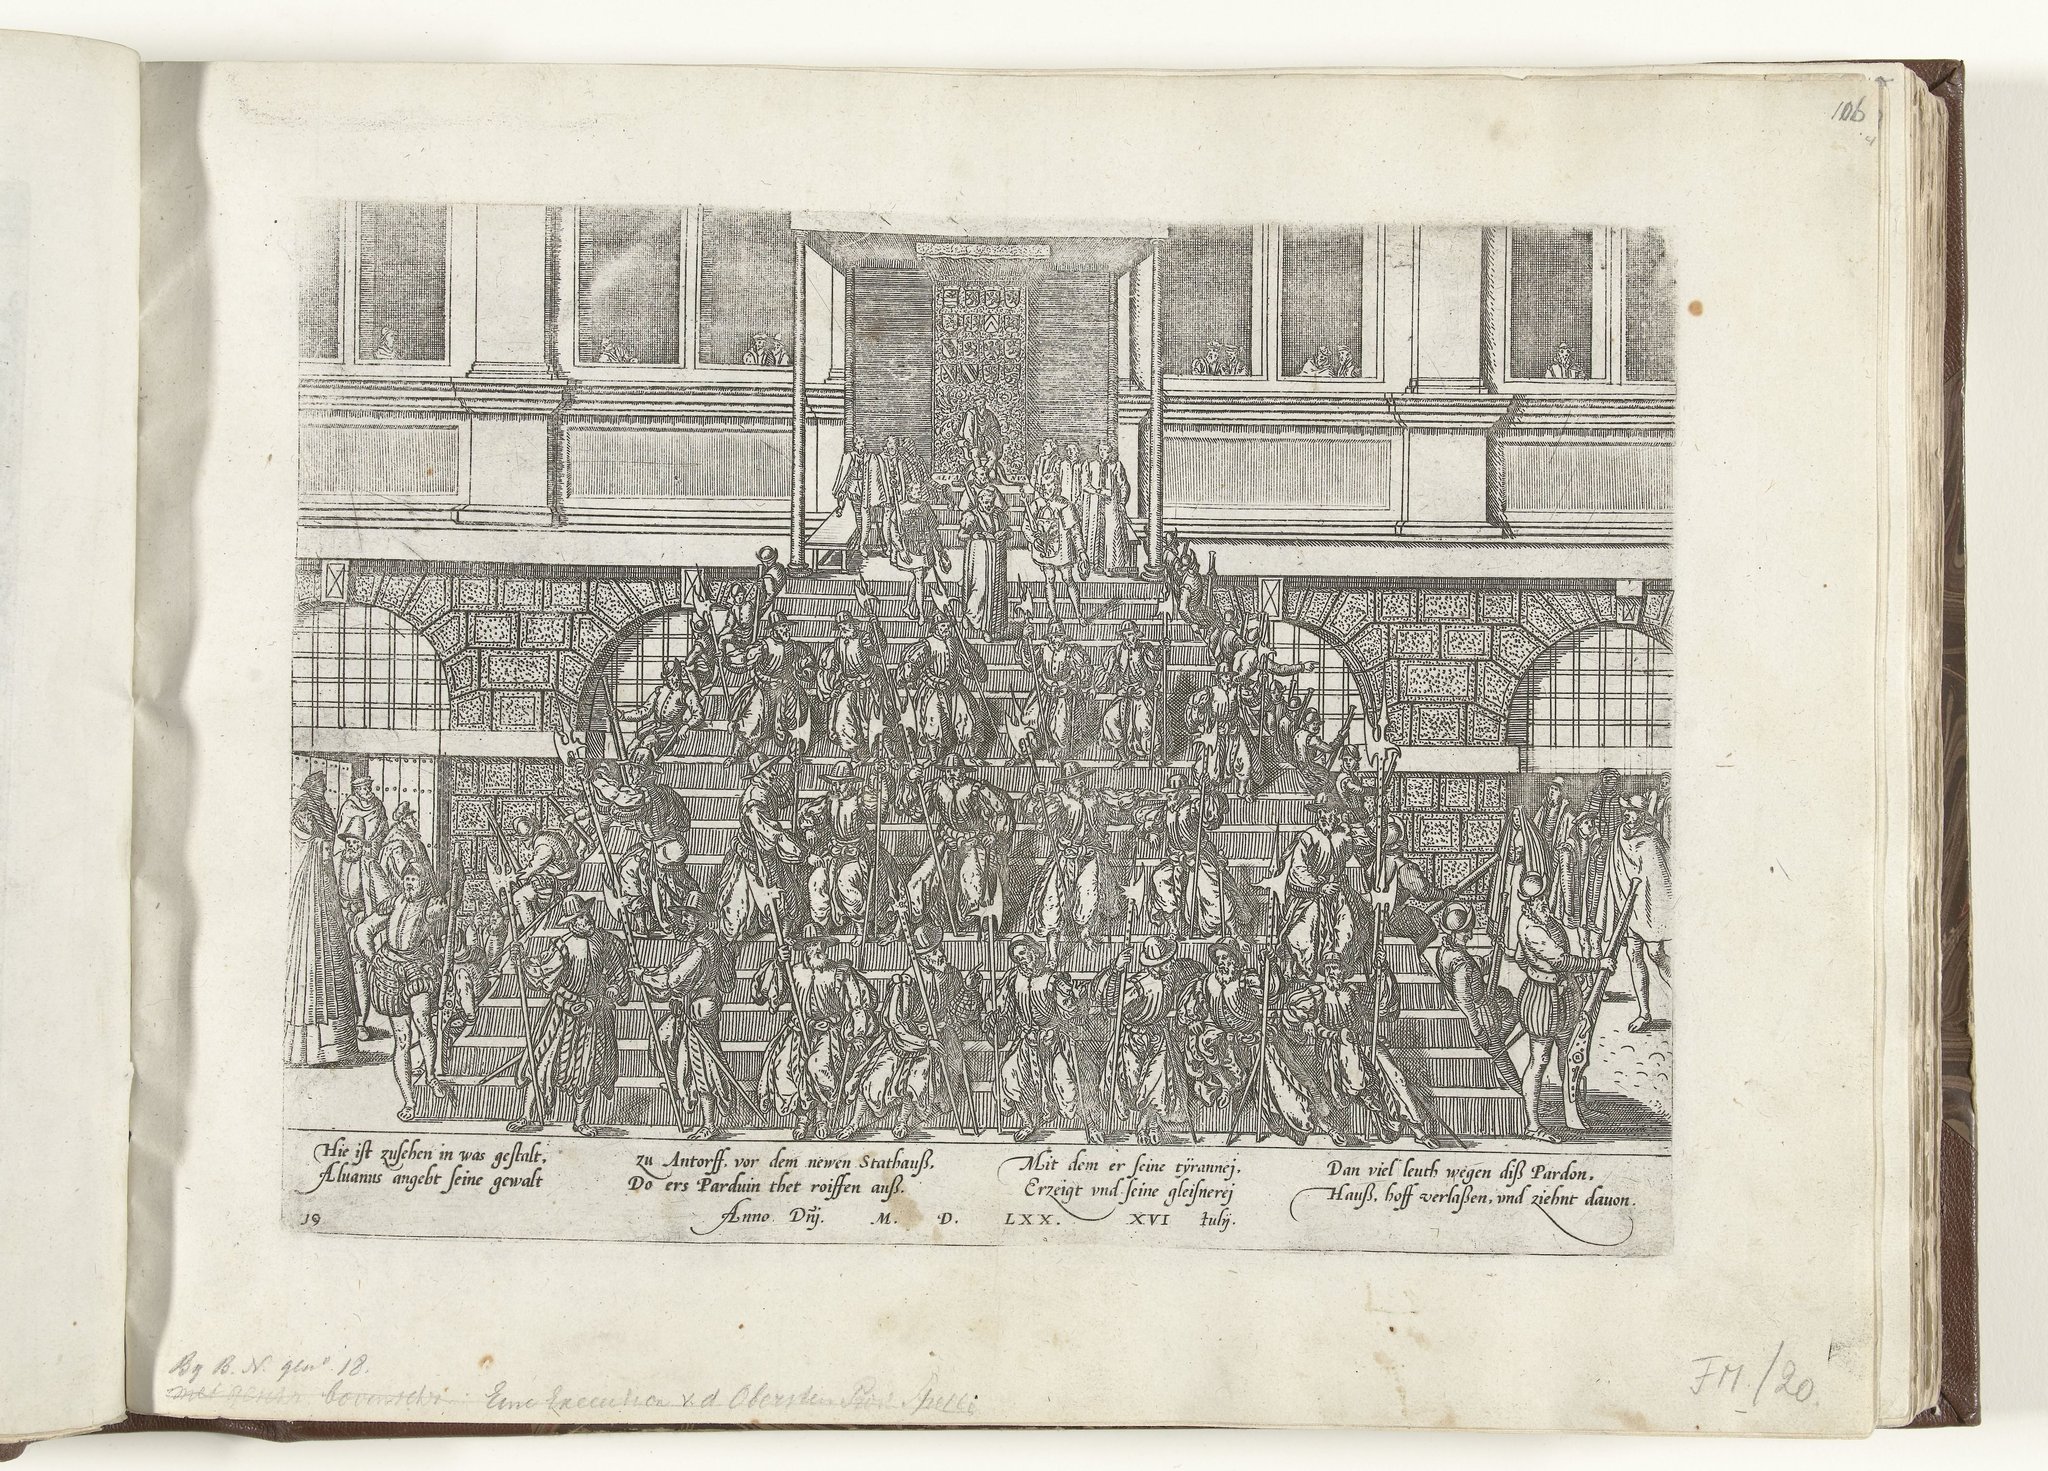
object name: print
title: Afkondiging van het Generaal Pardon, 1570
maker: frans hogenberg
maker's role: print maker, publisher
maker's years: 1538-1590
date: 1570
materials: paper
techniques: etching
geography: cologne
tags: fernando álvarez de toledo (3rd duke of alba), granting mercy; free pardon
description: Afkondiging van het Generaal Pardon, 16 juli 1570. Op een stellage voor het stadhuis van Antwerpen laat Alva het Algemeen Pardon voorlezen. Bovenaan zit Alva op een troon, op de trappen daaronder zitten soldaten. Met onderschrift van 8 regels in het Duits. Genummerd: 19.